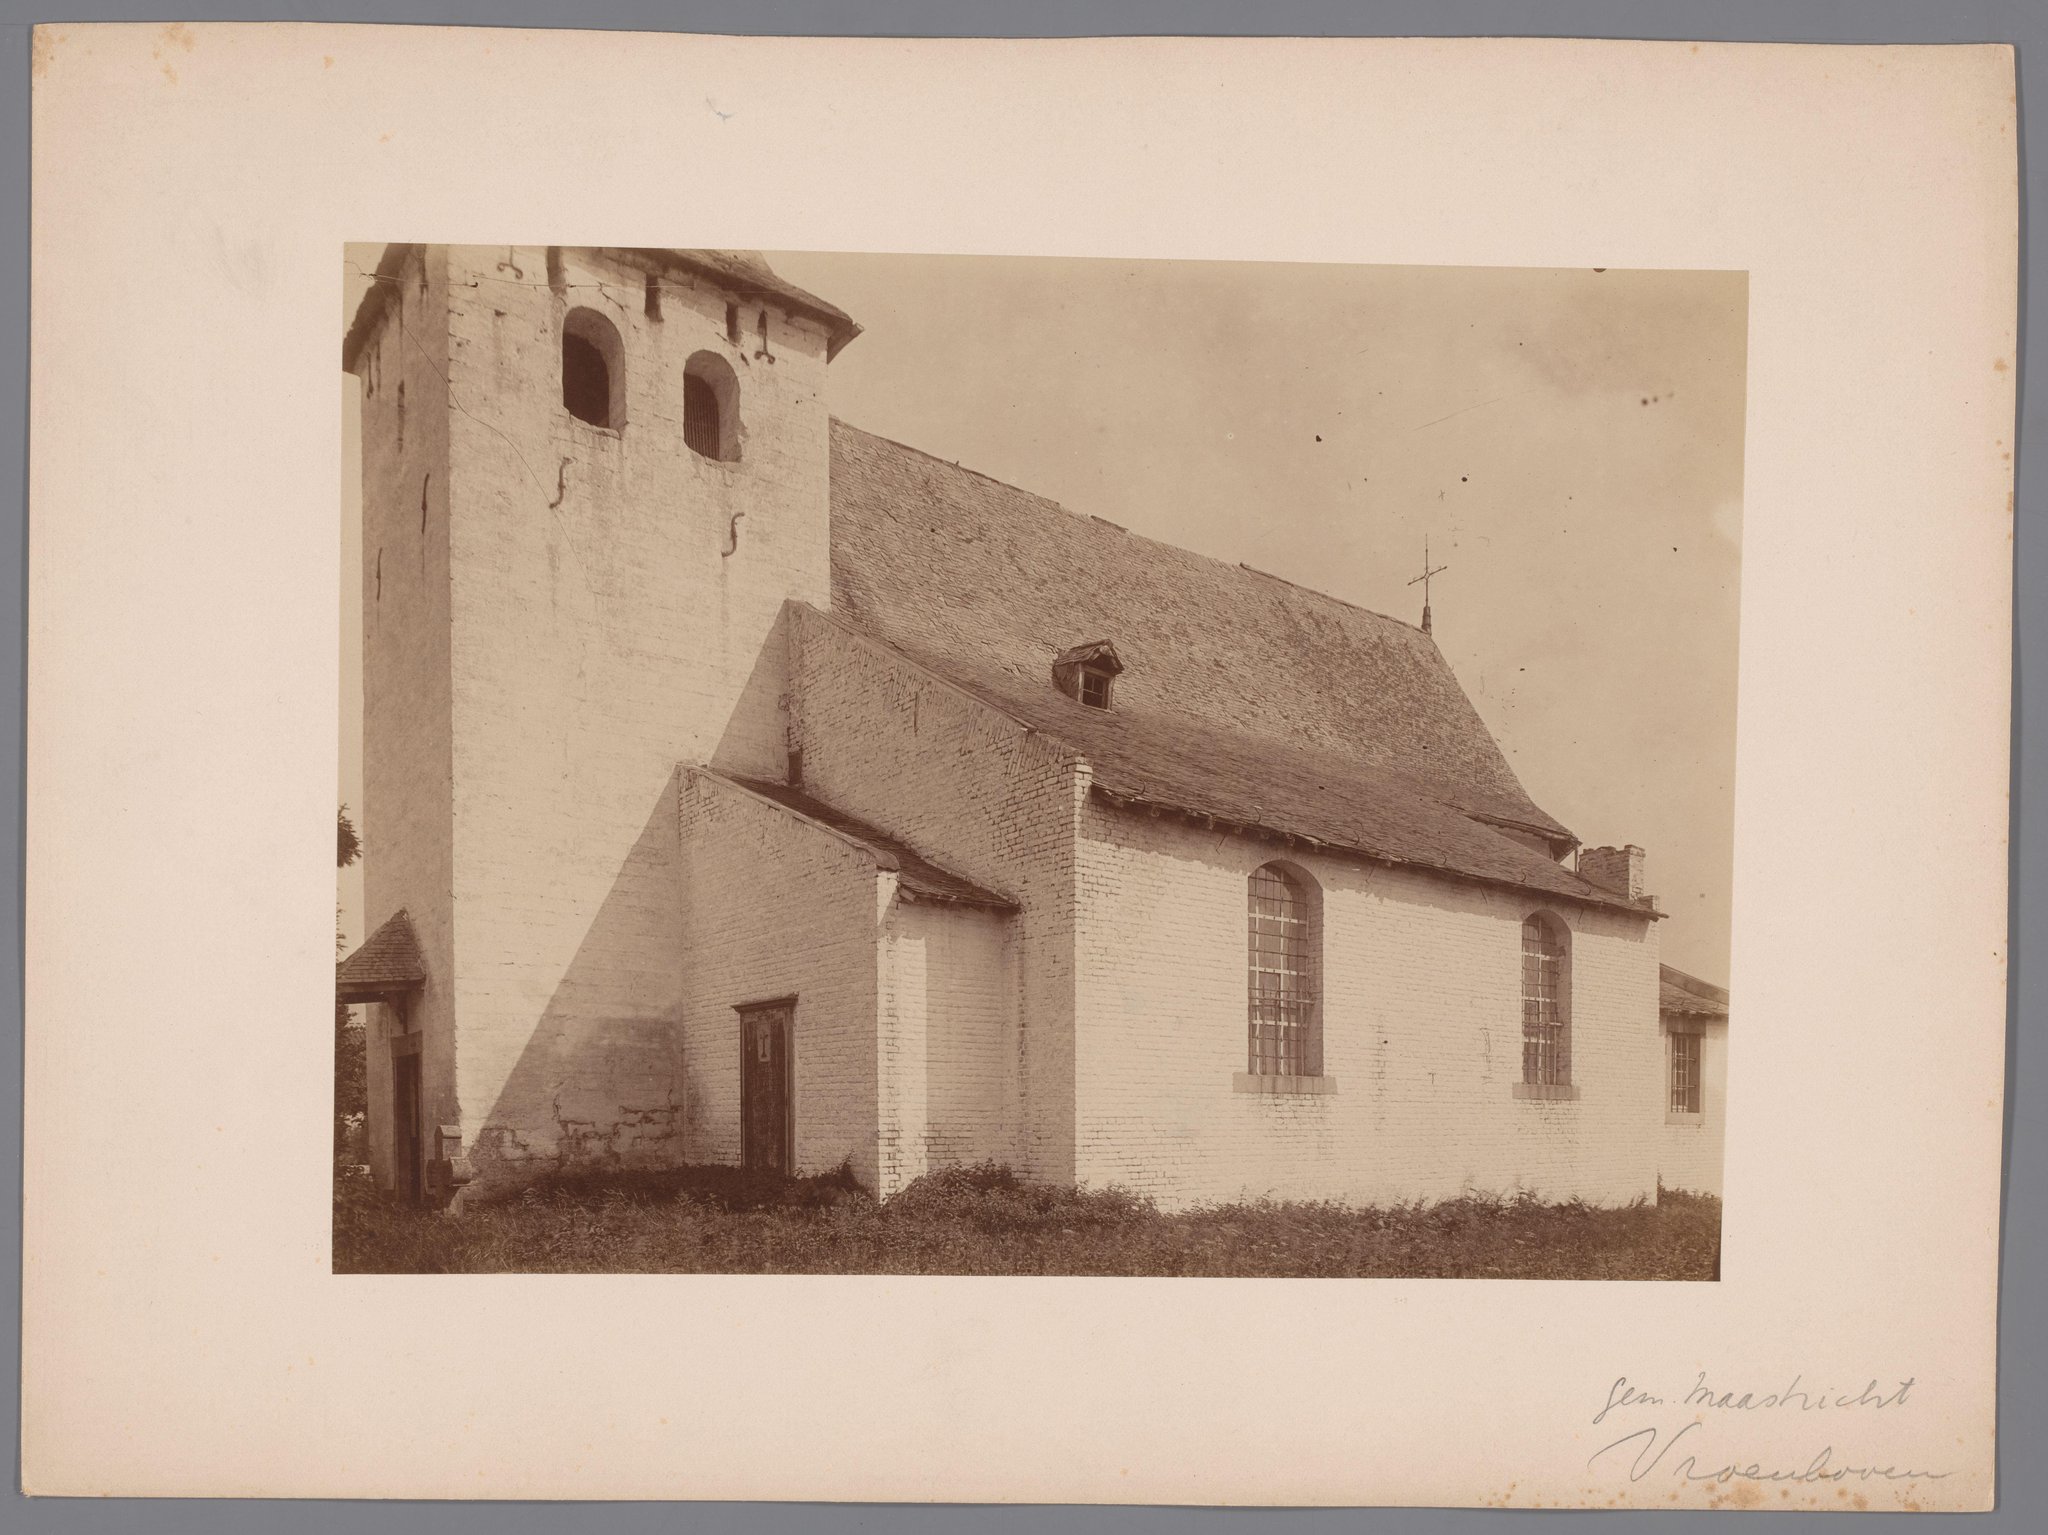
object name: photograph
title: Zuidzijde van de Rooms-Katholieke Kerk te Oud-Vroenhoven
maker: anoniem (monumentenzorg)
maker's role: fotograaf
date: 1895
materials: cardboard, photographic support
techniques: albumen print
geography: oud-vroenhoven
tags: church (exterior)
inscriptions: annotation: ‘R.K. Kerk te oud Vroenhoven (Vroenhoven) (L.)/ bij Maastricht/ Aug 1895’, annotation: ‘N:278 N:1003’, annotation: ‘gem. Maastricht/ Vroenhoven’